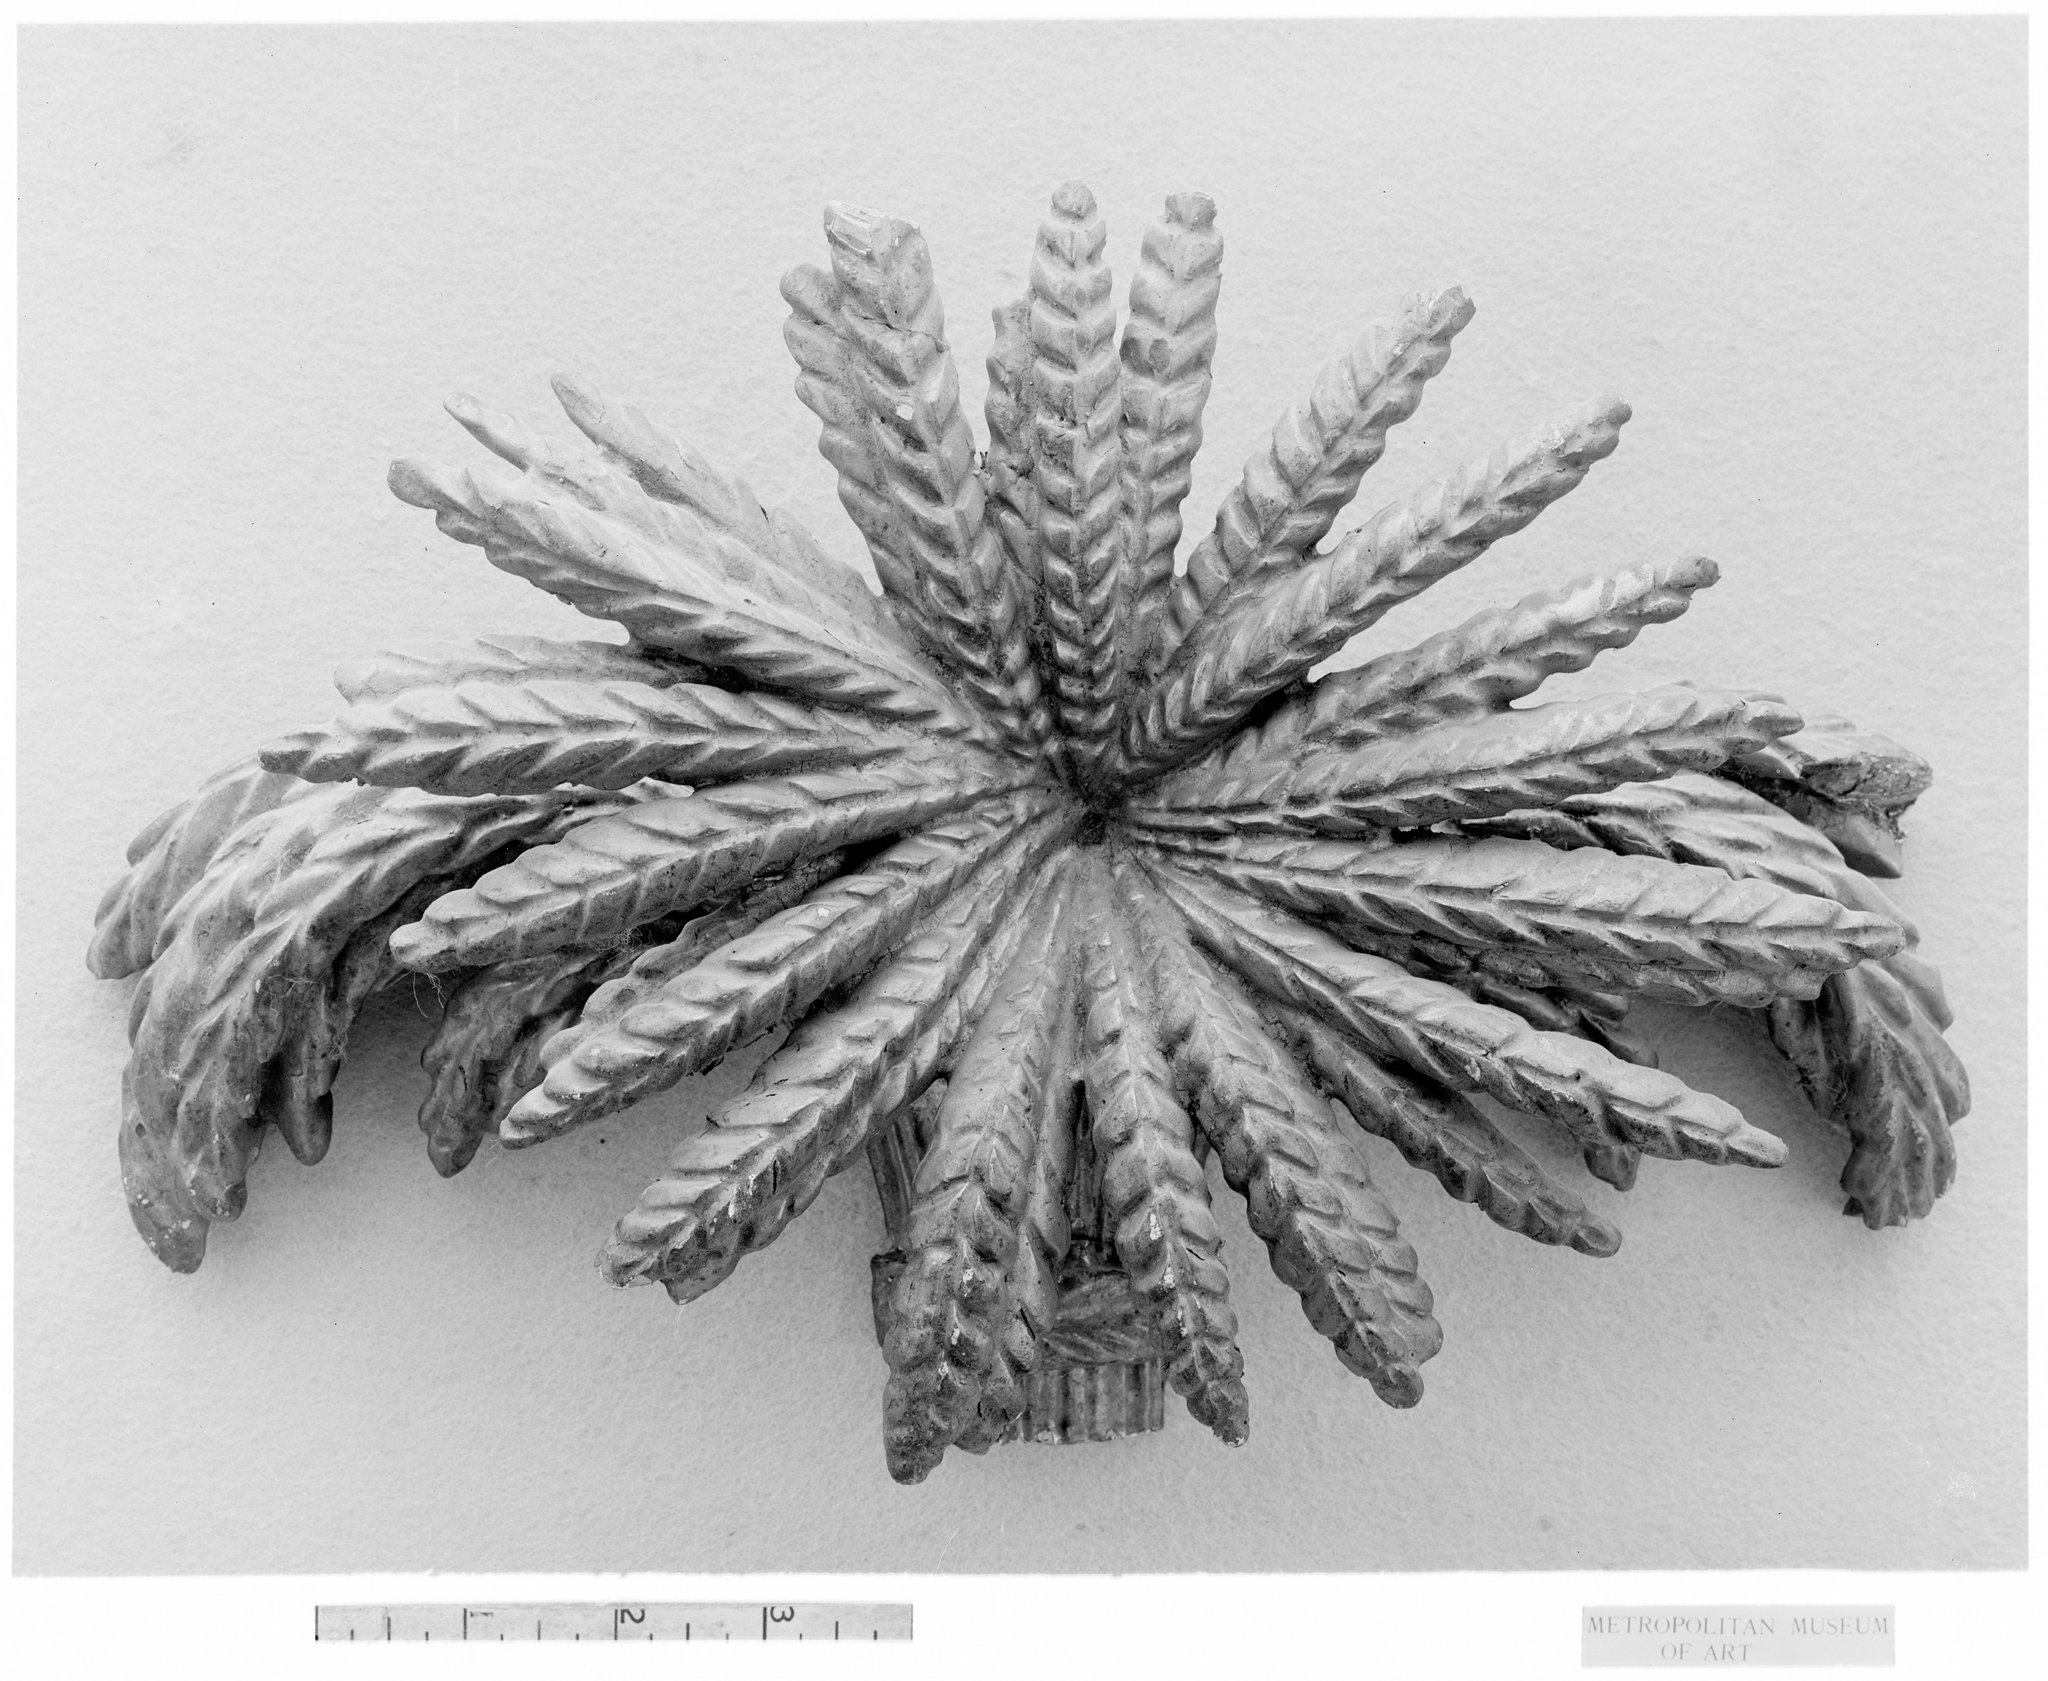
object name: fronton detail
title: Fronton ornament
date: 1701-1800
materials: gilt, wood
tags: leaves